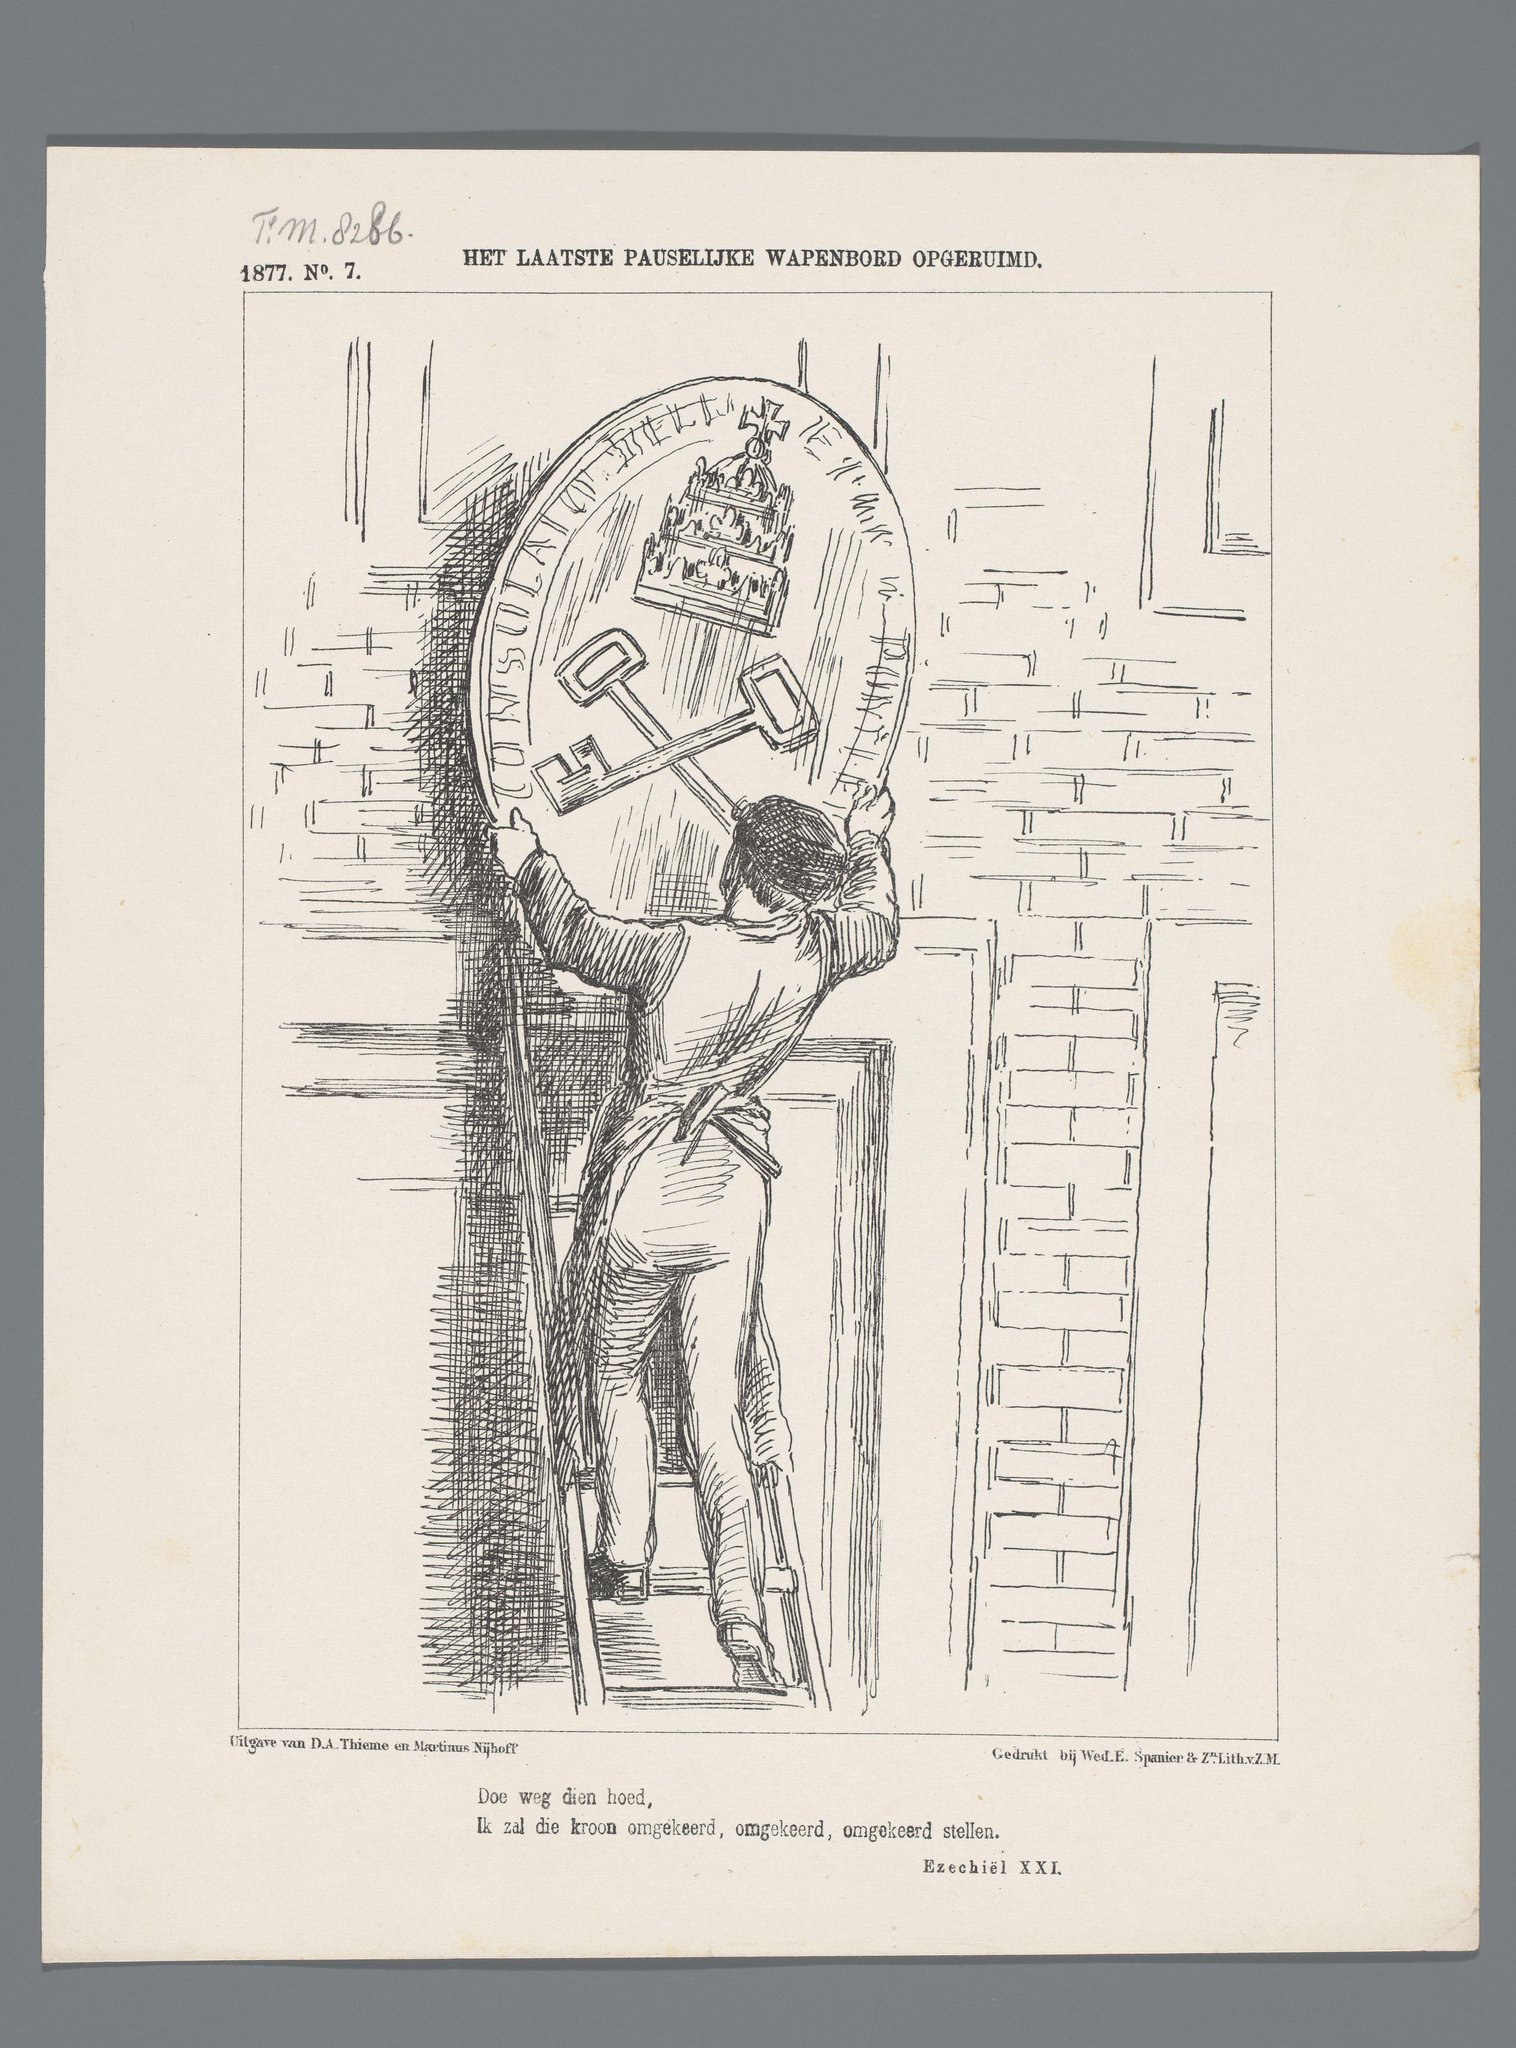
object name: cartoon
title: Het laatste pauselijke wapenbord opgeruimd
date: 1877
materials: paper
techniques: lithograph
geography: netherlands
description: Spotprent . Plaat verschenen bij het weekblad De Nederlandsche Spectator, nr. 7, 1877.